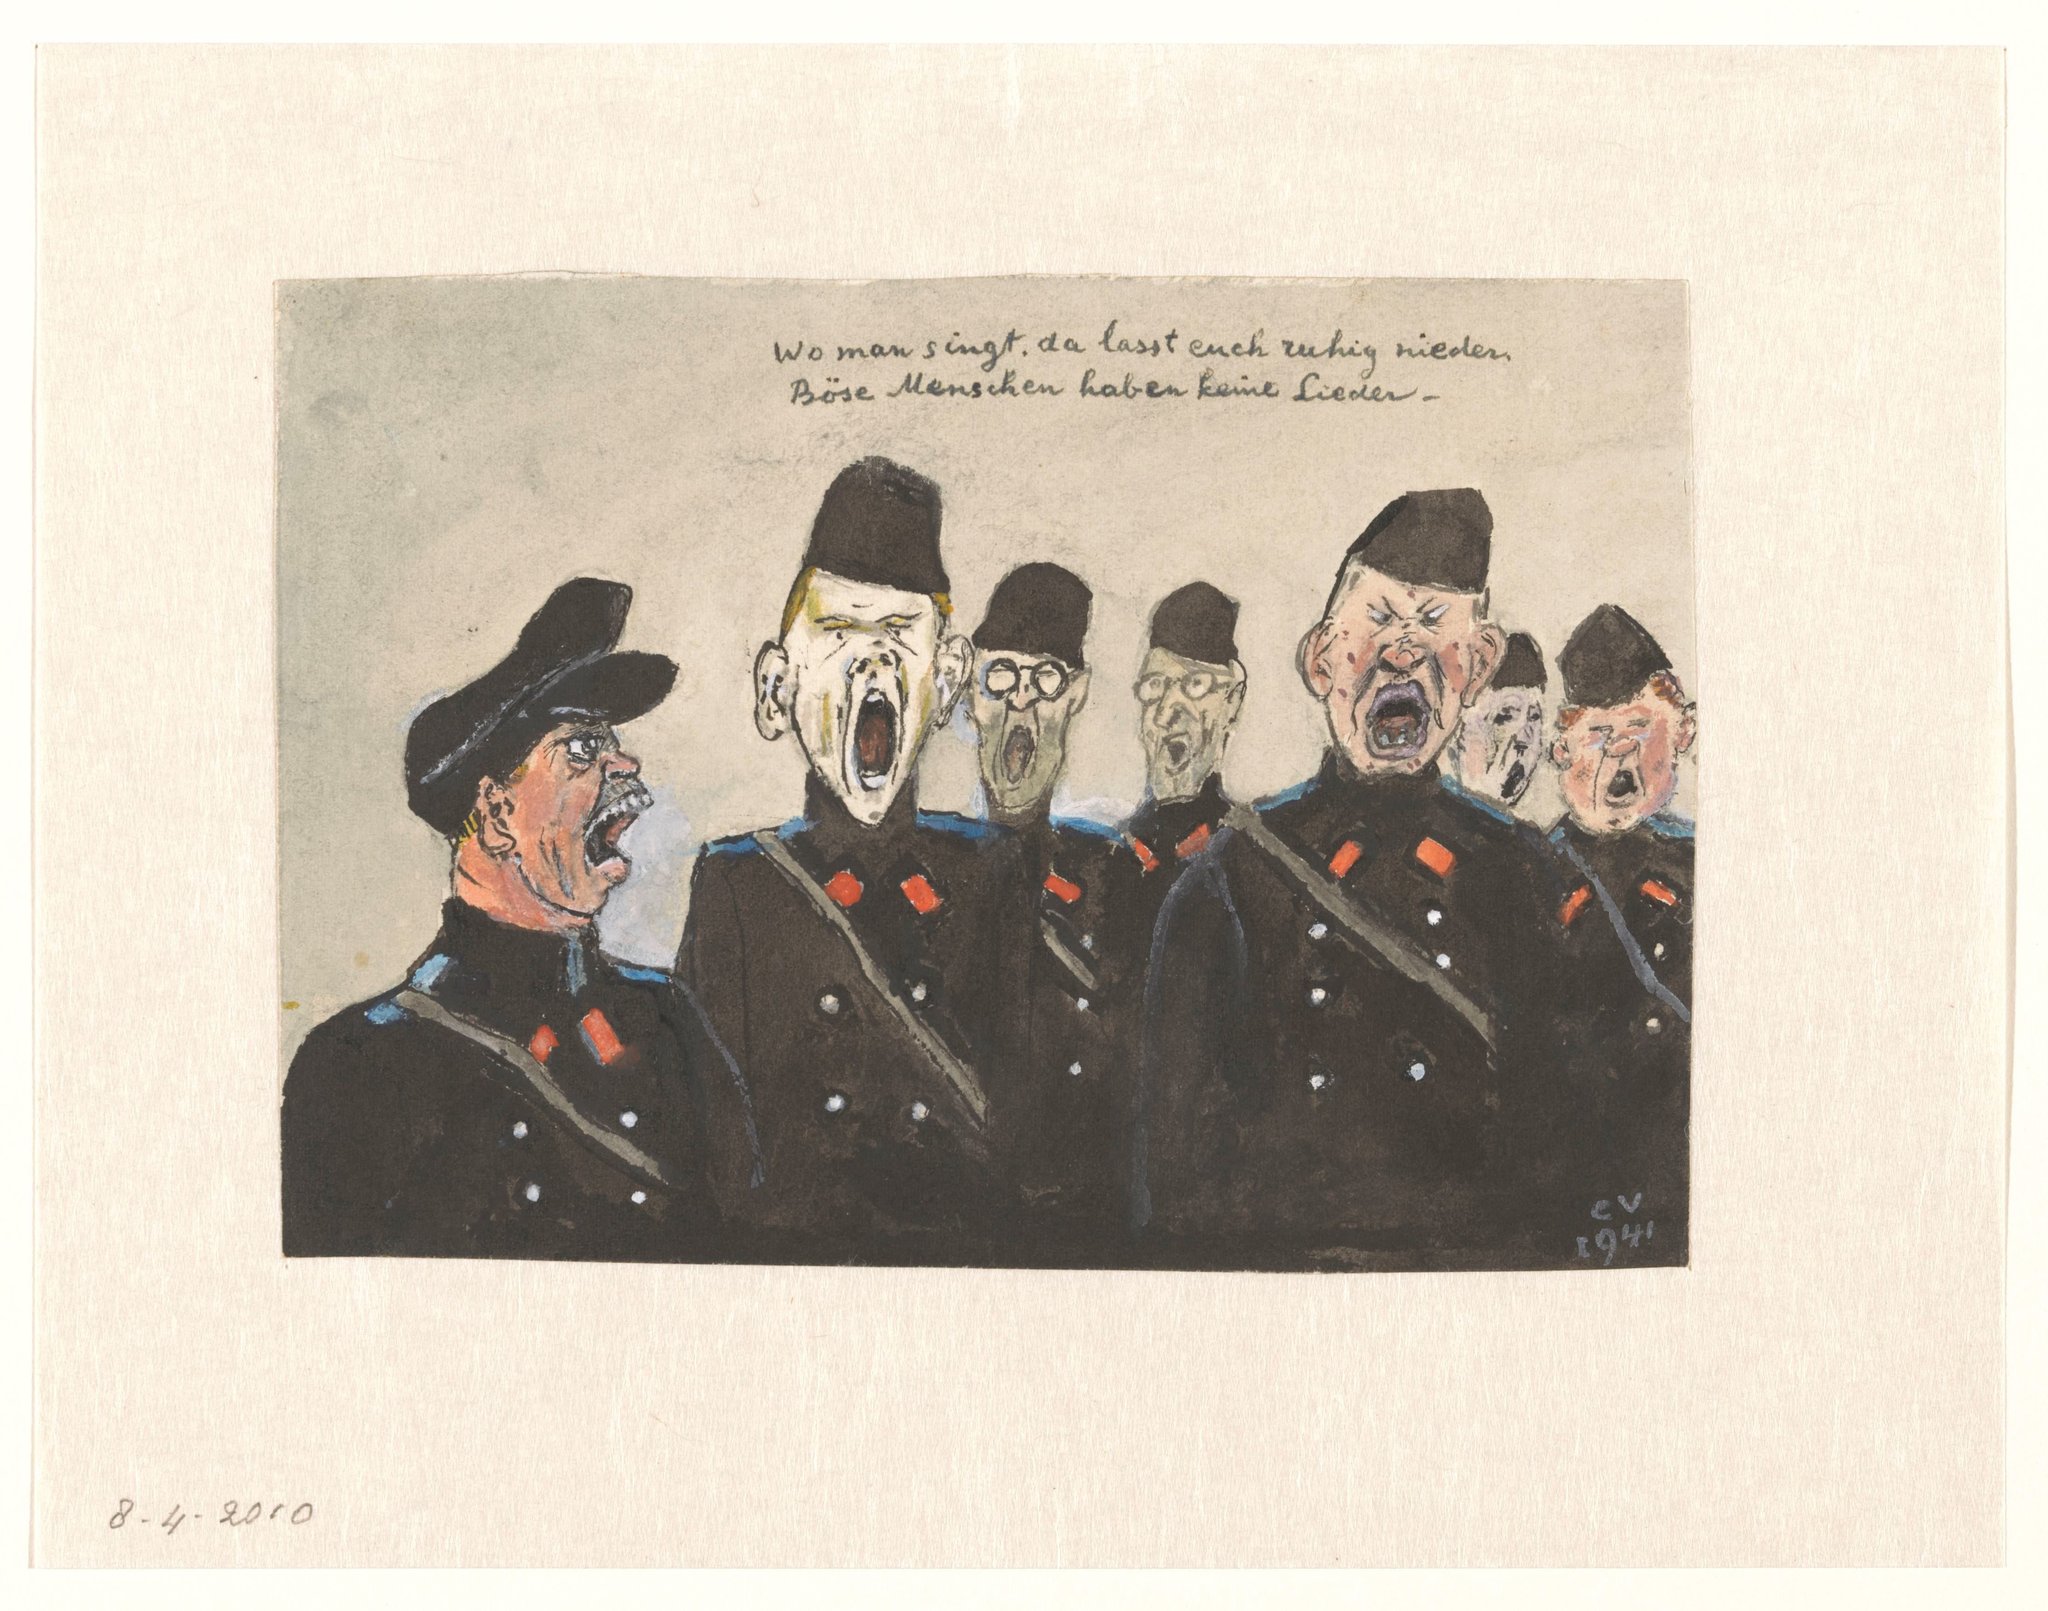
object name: drawing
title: Treincontroleur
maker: gerrit willem dijsselhof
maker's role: designer, draughtsman, print maker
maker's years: 1866-1924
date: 1876-1924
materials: chalk, paper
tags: railway, tramway; rack railway